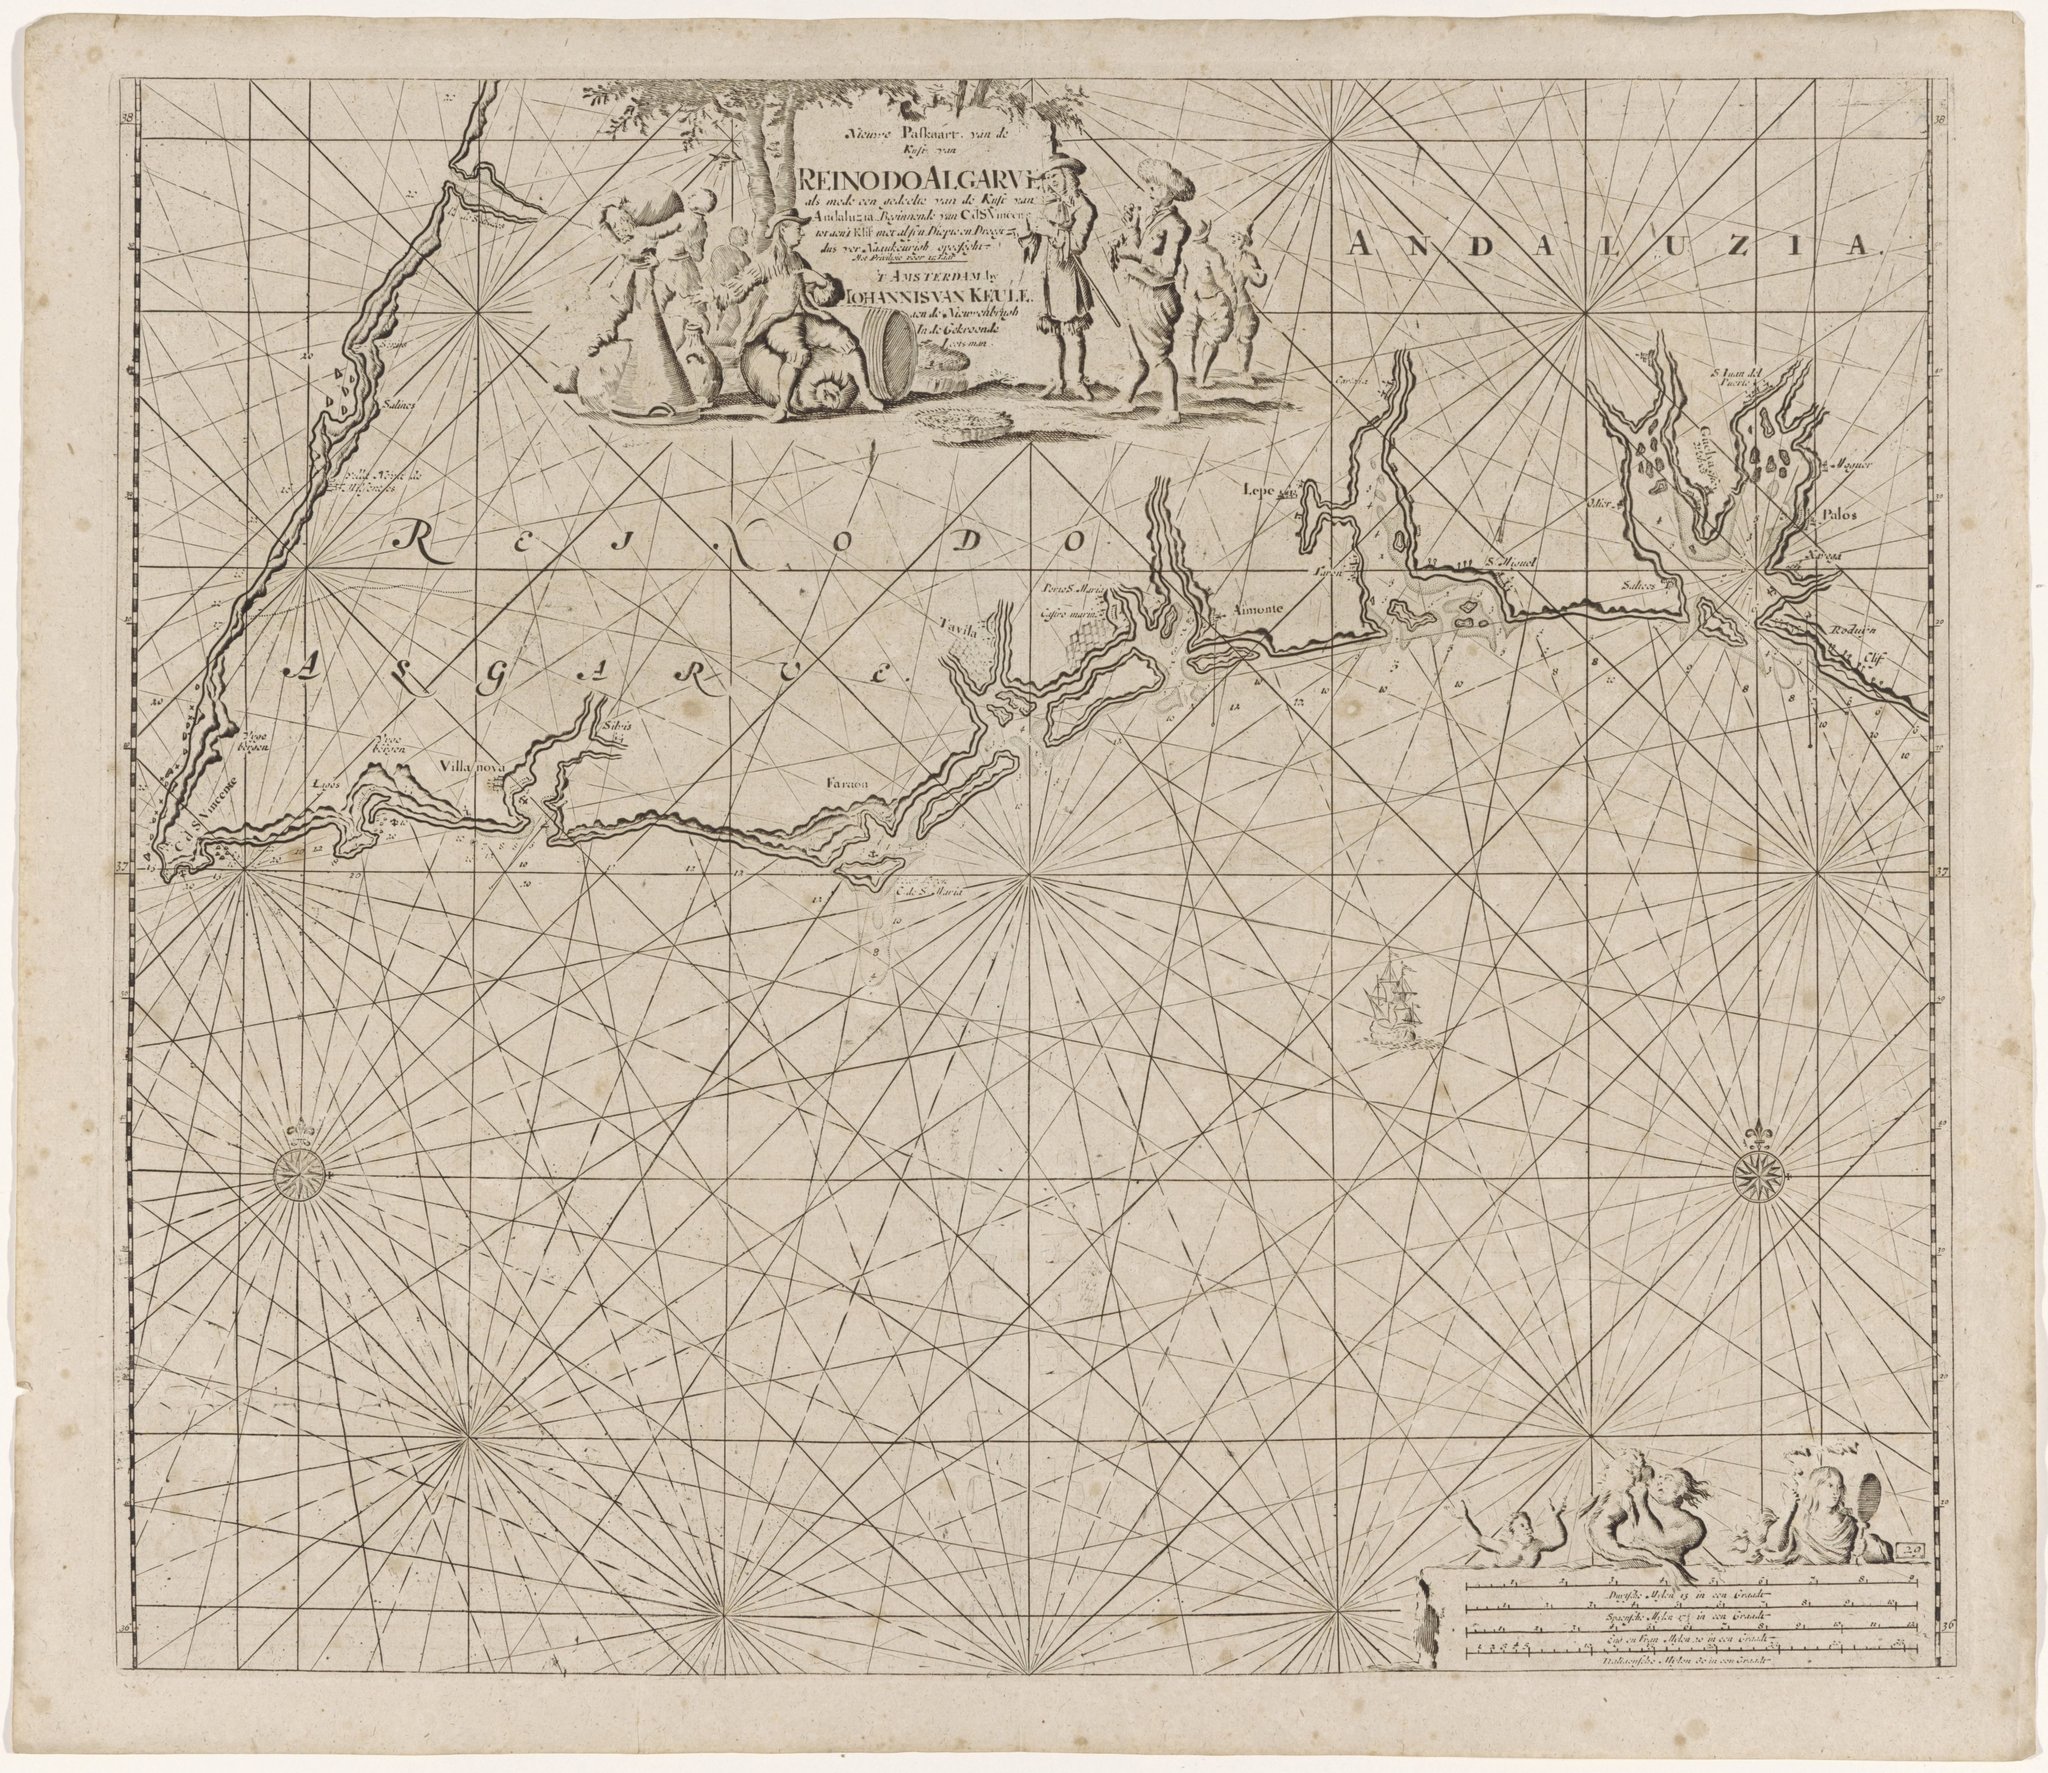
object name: print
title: Zeekaart van een deel van de zuidkust van Portugal en Spanje met de Algarve en Andalusië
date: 1681-1803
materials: paper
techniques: engraving, etching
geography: amsterdam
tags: bargaining, merman, merman - aa - mermaid, siren, mirror, seaman, spain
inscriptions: collector's mark: Lugt 2228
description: Zeekaart van een deel van de zuidkust van Portugal en Spanje met de Algarve en Andalusië, met twee kompasrozen, het Noorden ligt boven. Middenboven een cartouche met de titel en het adres van de uitgever, omringd door een matroos en enkele handelslieden. Rechtsonder een zeemeermin en twee meermannen bij de schaalverdeling, weergegeven in Duitse, Spaanse en Engelse of Franse mijlen (schaal: c. 1:450.000).